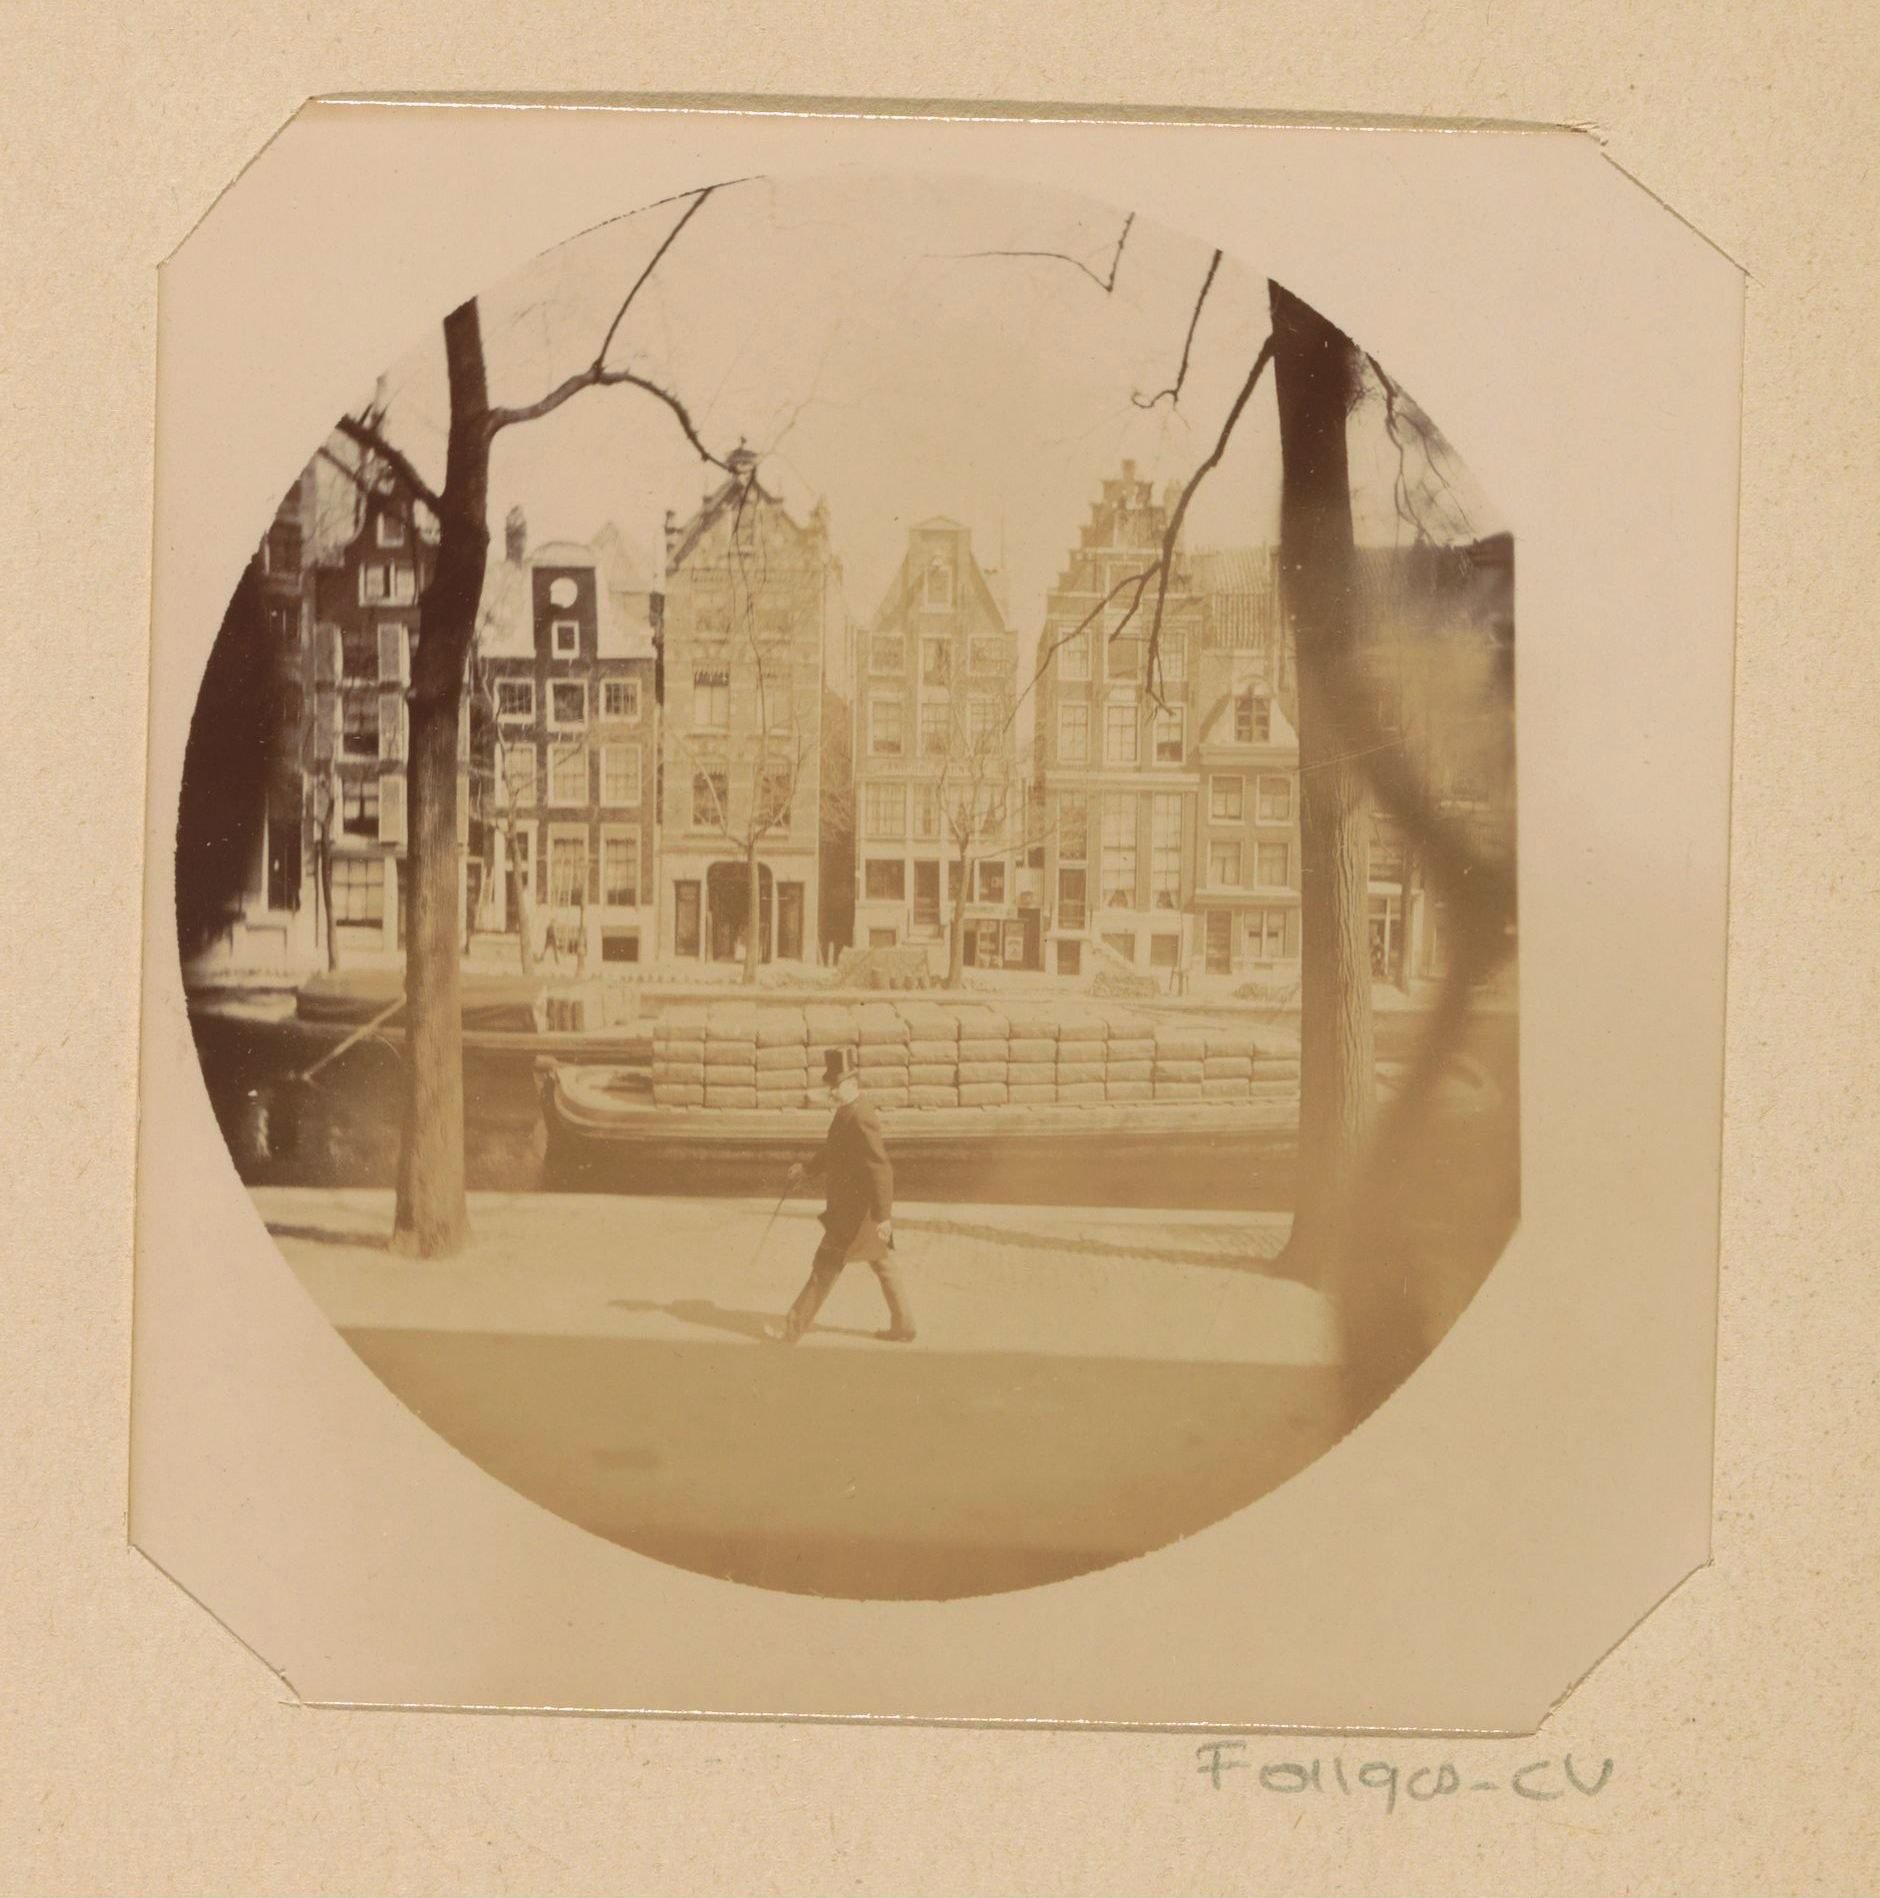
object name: photograph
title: Shots in Amsterdam, Warnemünde, and Warnsborn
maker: johanna margaretha piek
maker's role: fotograaf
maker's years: 1870-1947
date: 1889-1893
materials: paper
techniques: gelatin silver print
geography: amsterdam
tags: urban housing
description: The photograph of Herengracht was the key for identifying the album as belonging to the Pieks. It was taken from the house at number 258, where the family lived. We see the couple and their son with his classmates on an excursion to the Oostzee. The street photograph is an impression of German kaiser Wilhelm II’s visit to Amsterdam. The round, 9 centimetre photographs were taken with the improved Kodak No. 2.